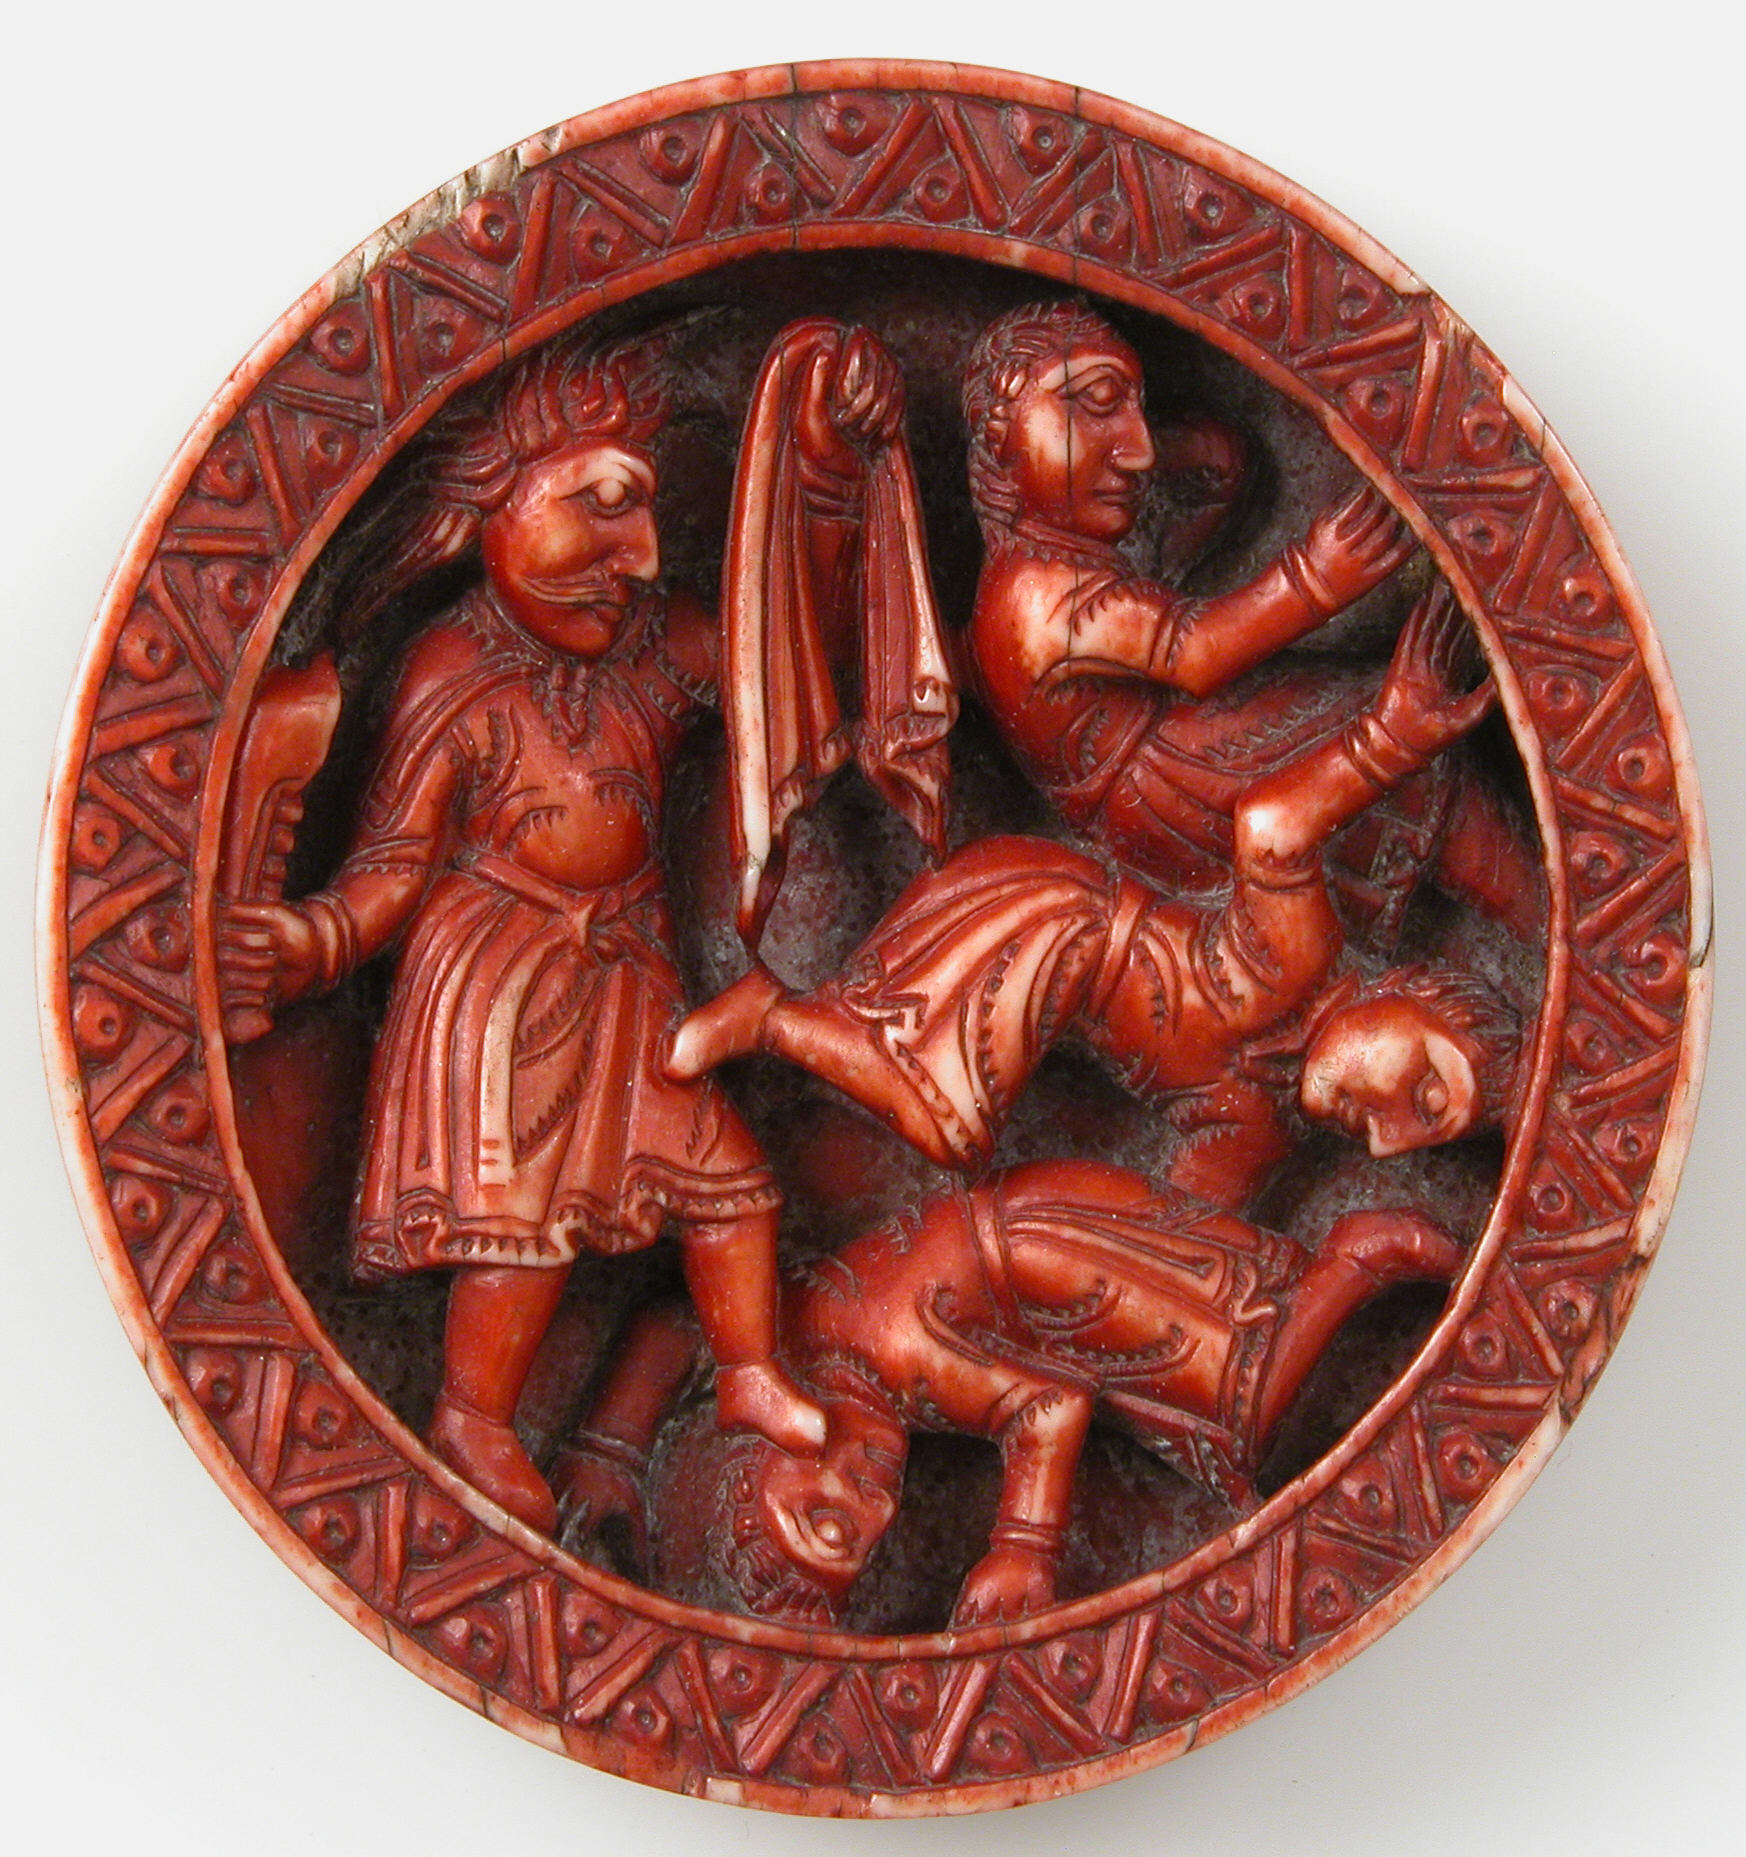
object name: game piece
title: Game Piece with Samson Slaying the Philistines with the Jawbone of an Ass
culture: german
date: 1140-1150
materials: ivory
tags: men,samson,games